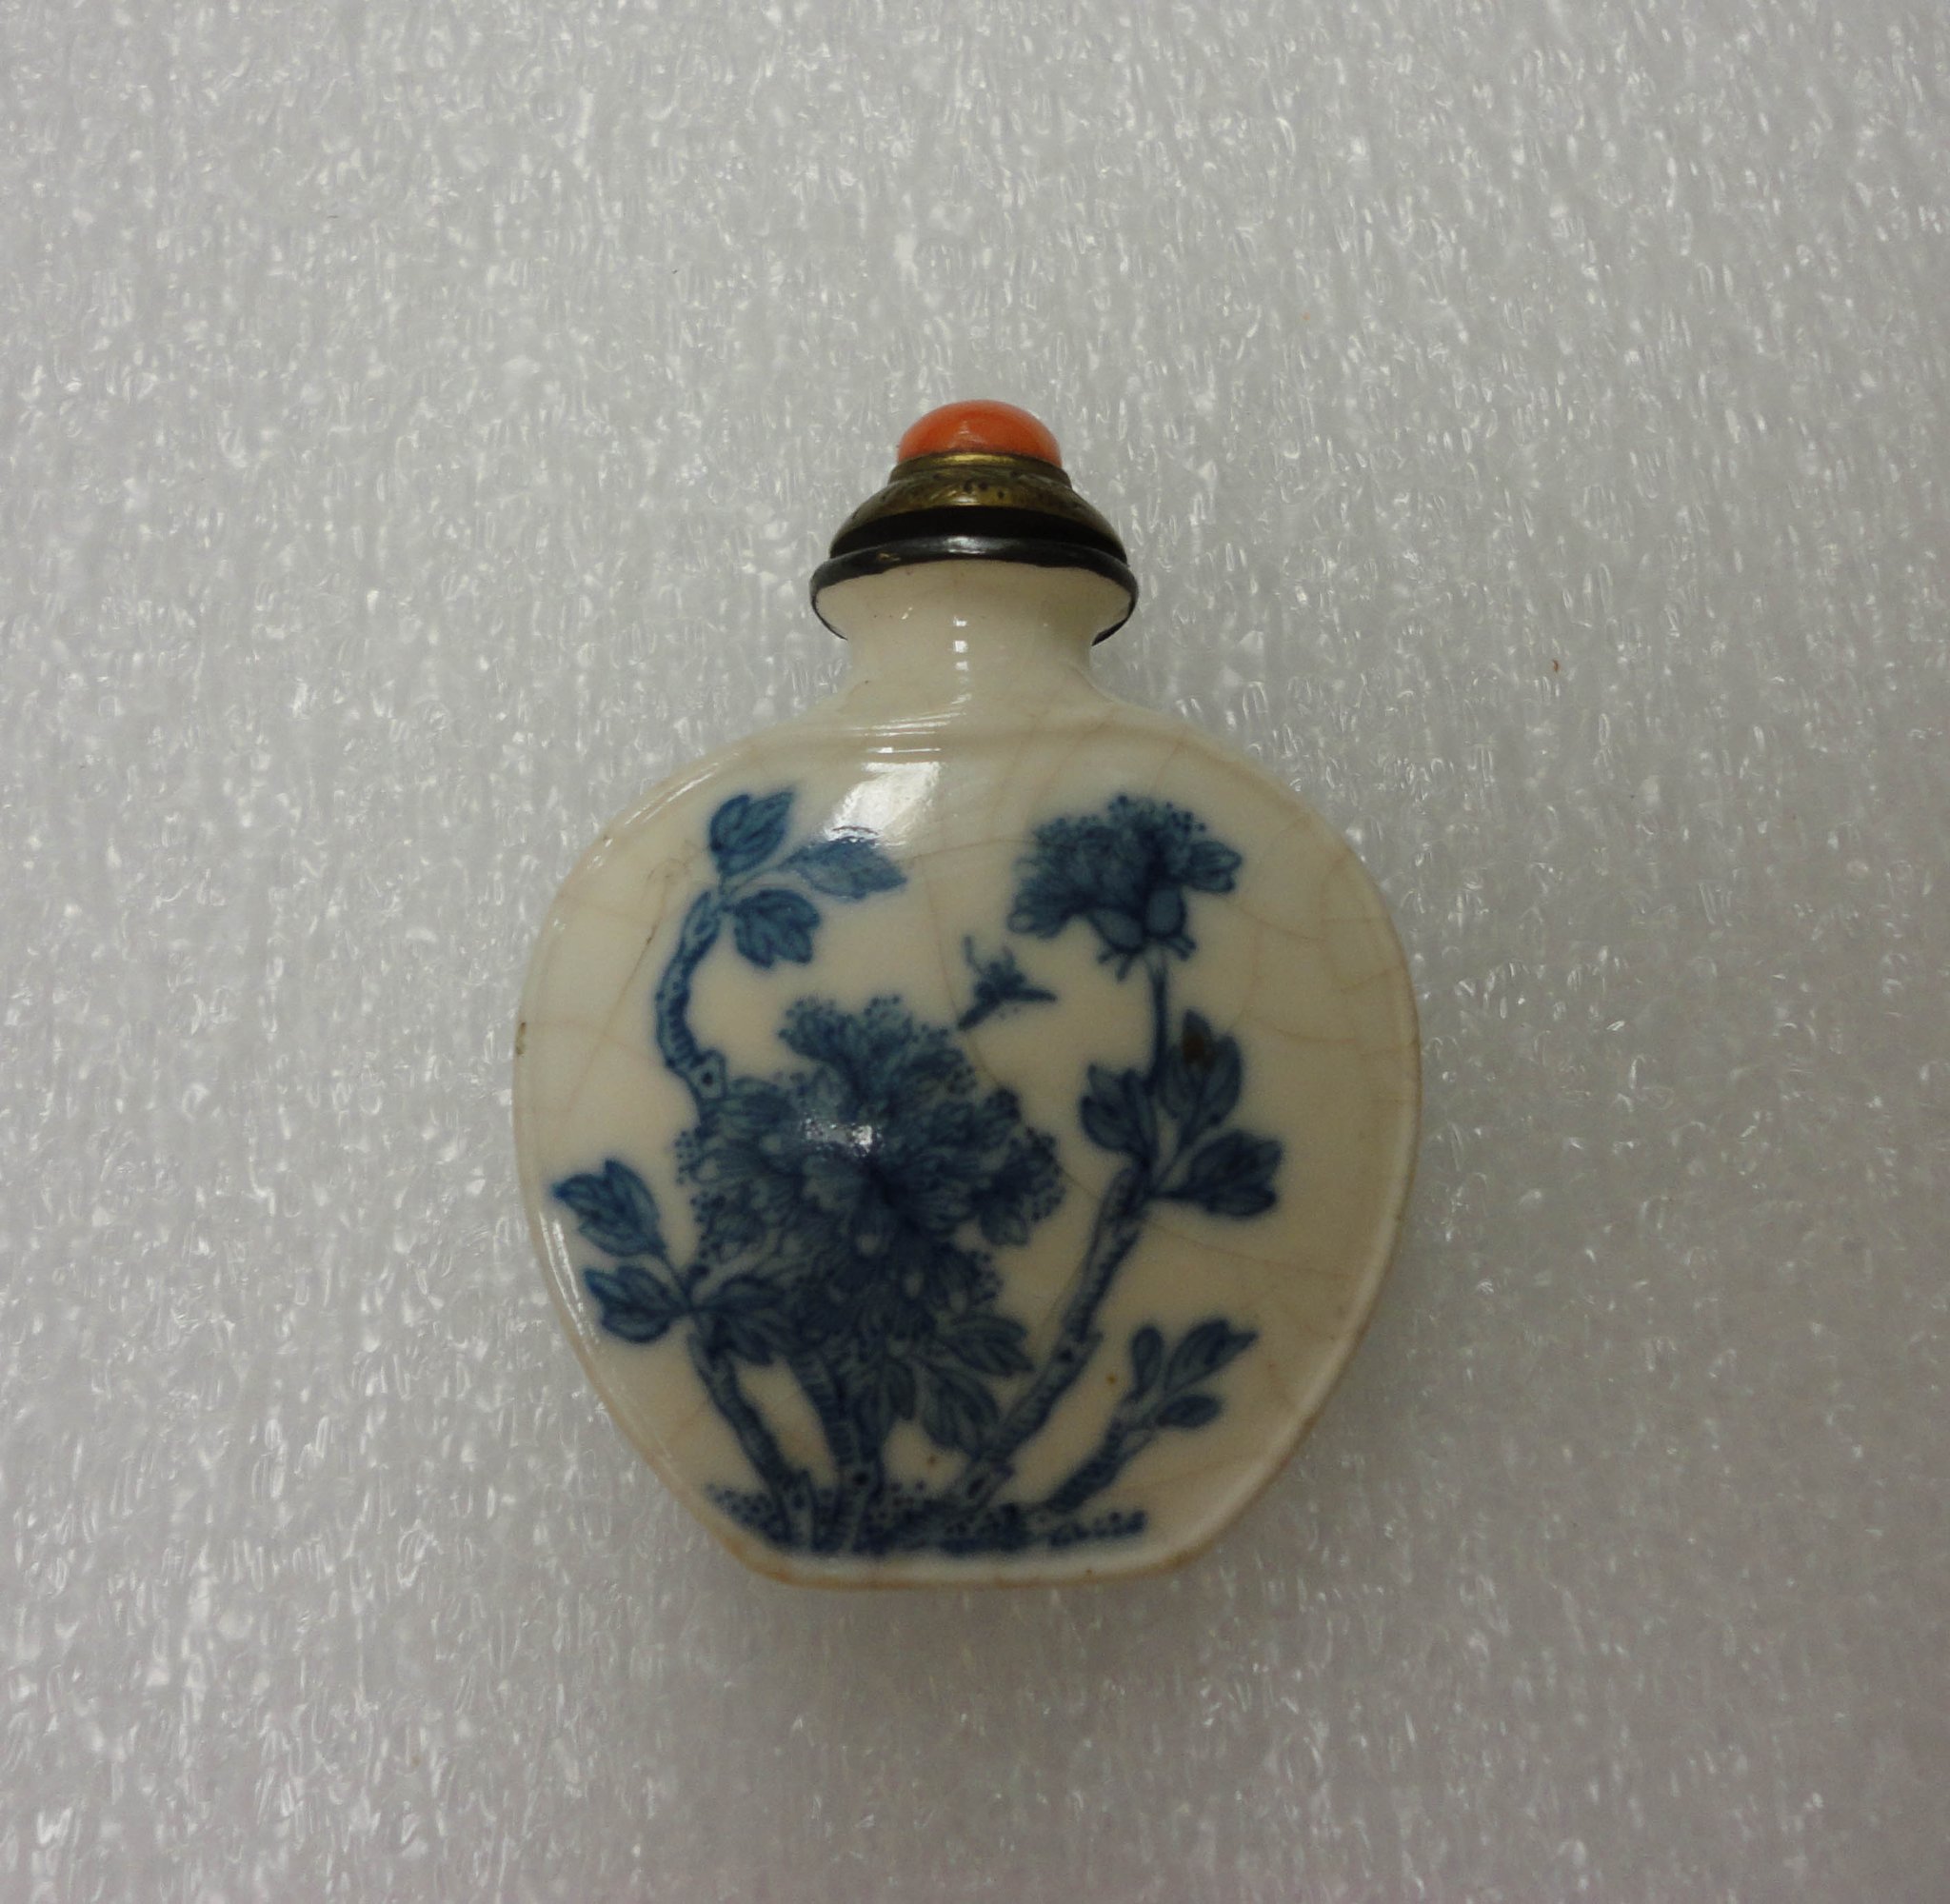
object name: snuff bottle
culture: chinese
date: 1736-1795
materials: soft paste porcelain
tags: flowers